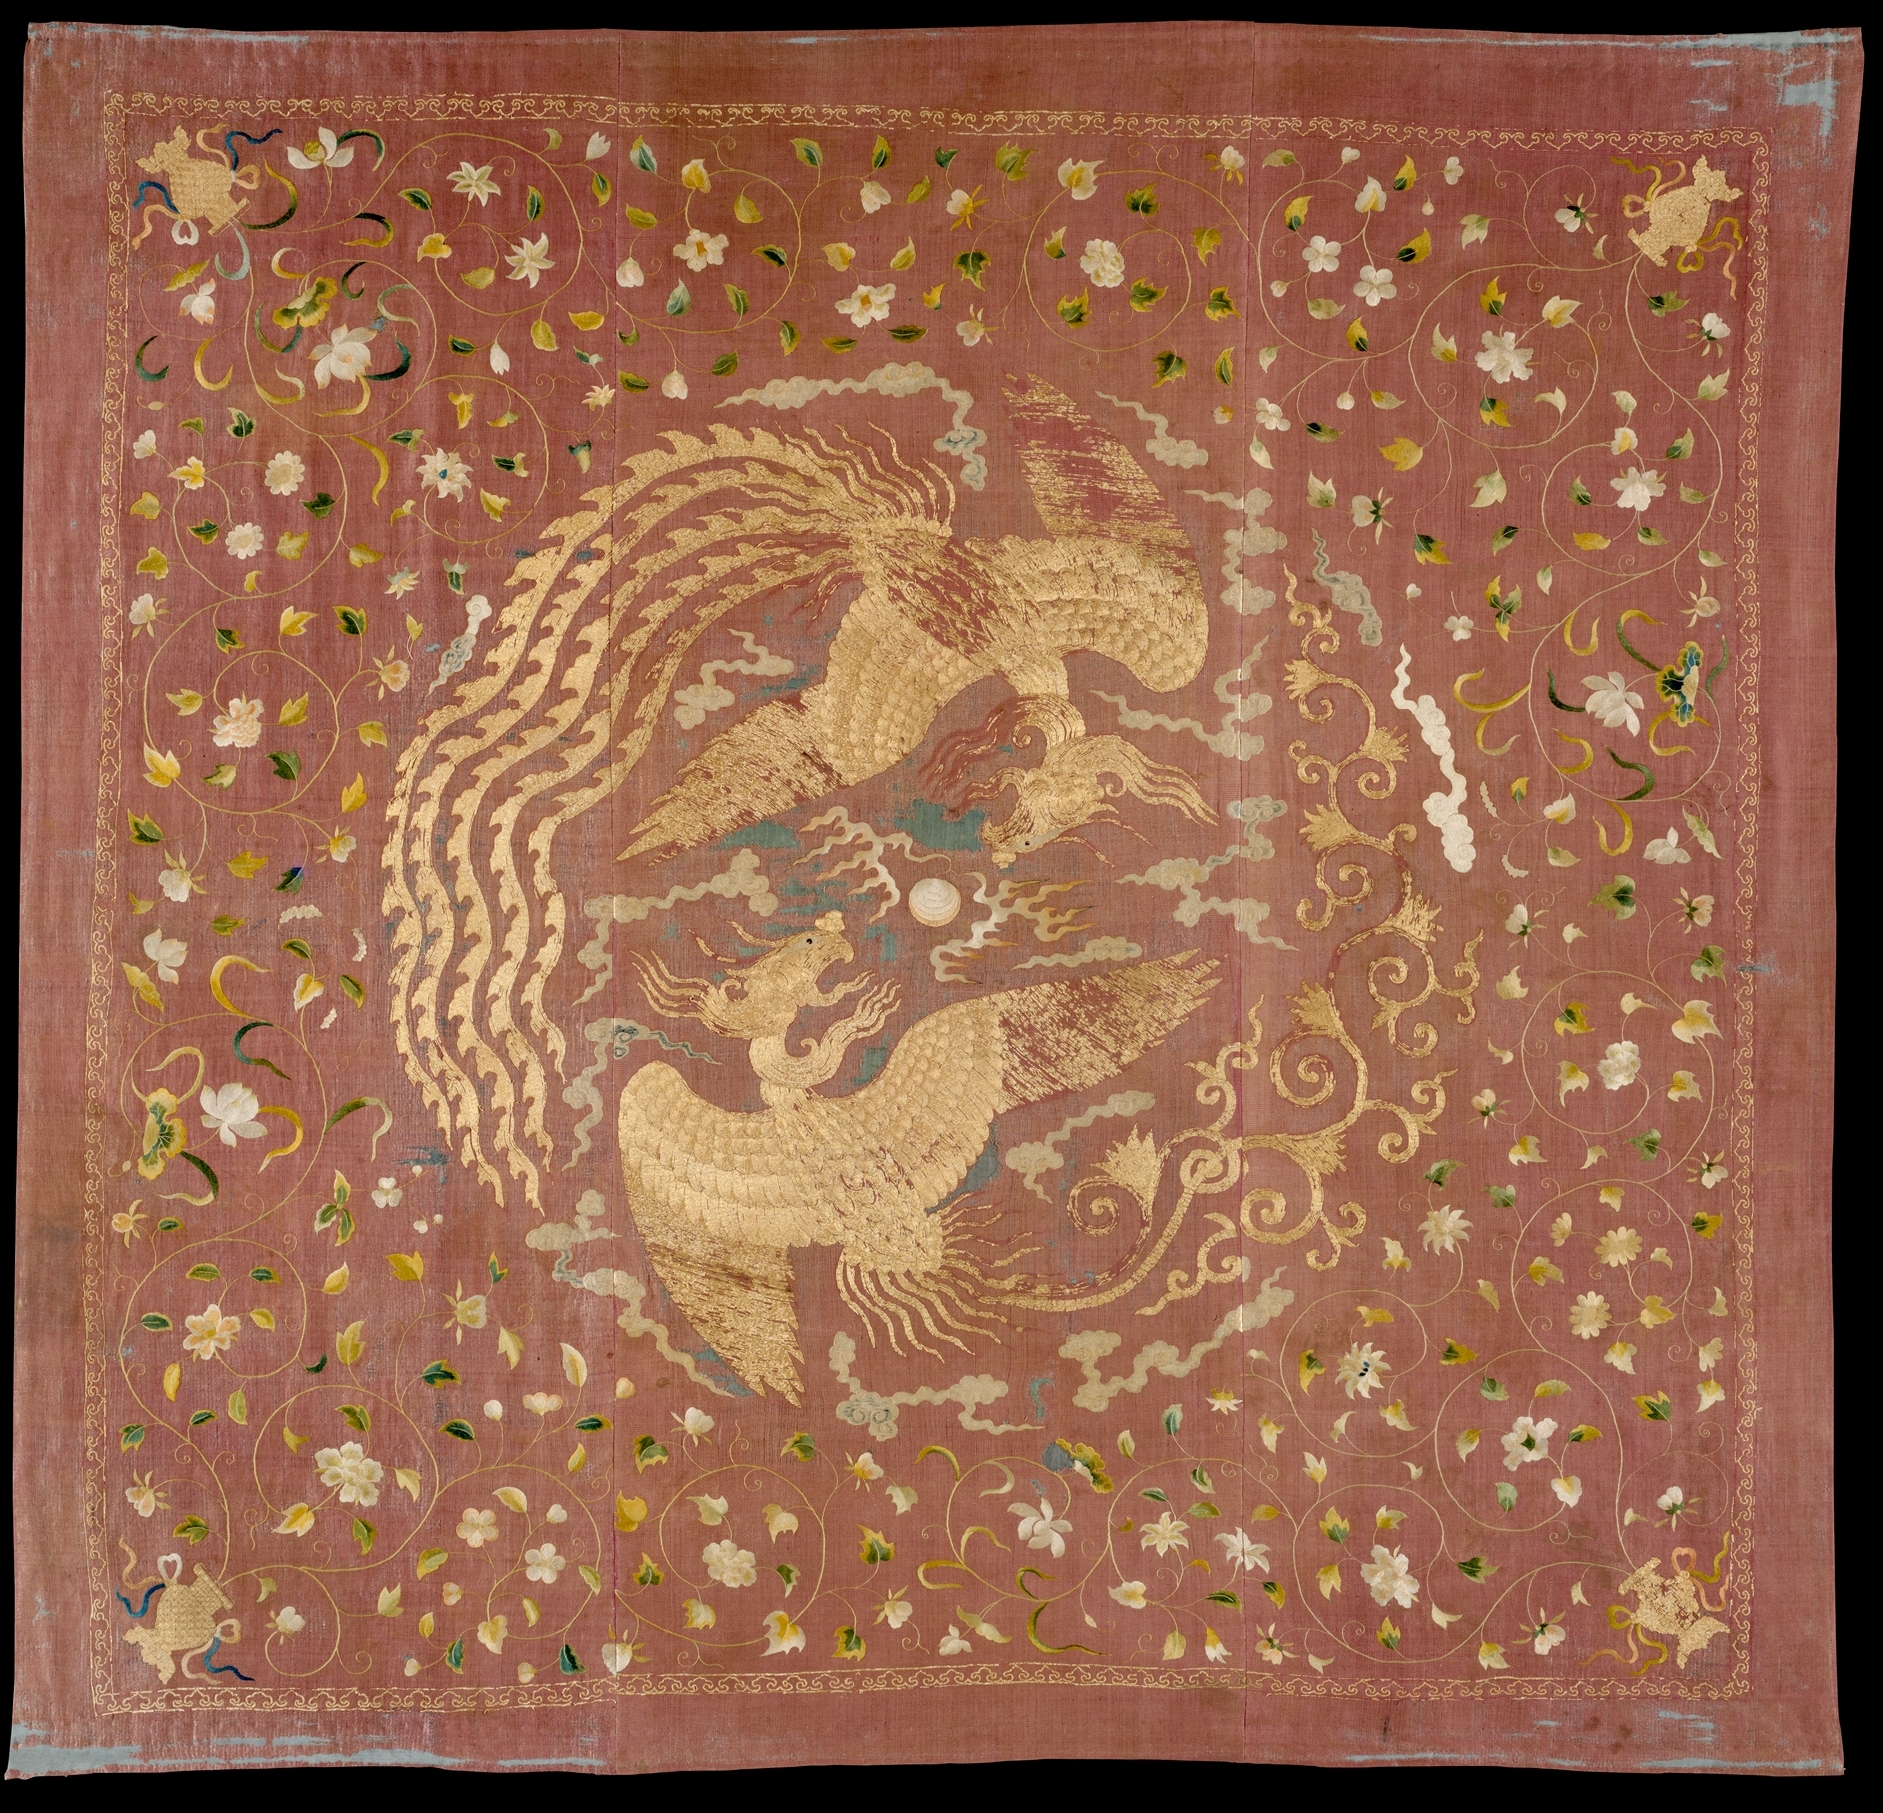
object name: panel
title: Panel with Phoenixes and Flowers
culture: chinese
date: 1301-1400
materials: textile, metal thread, silk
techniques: embroidery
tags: phoenix,flowers